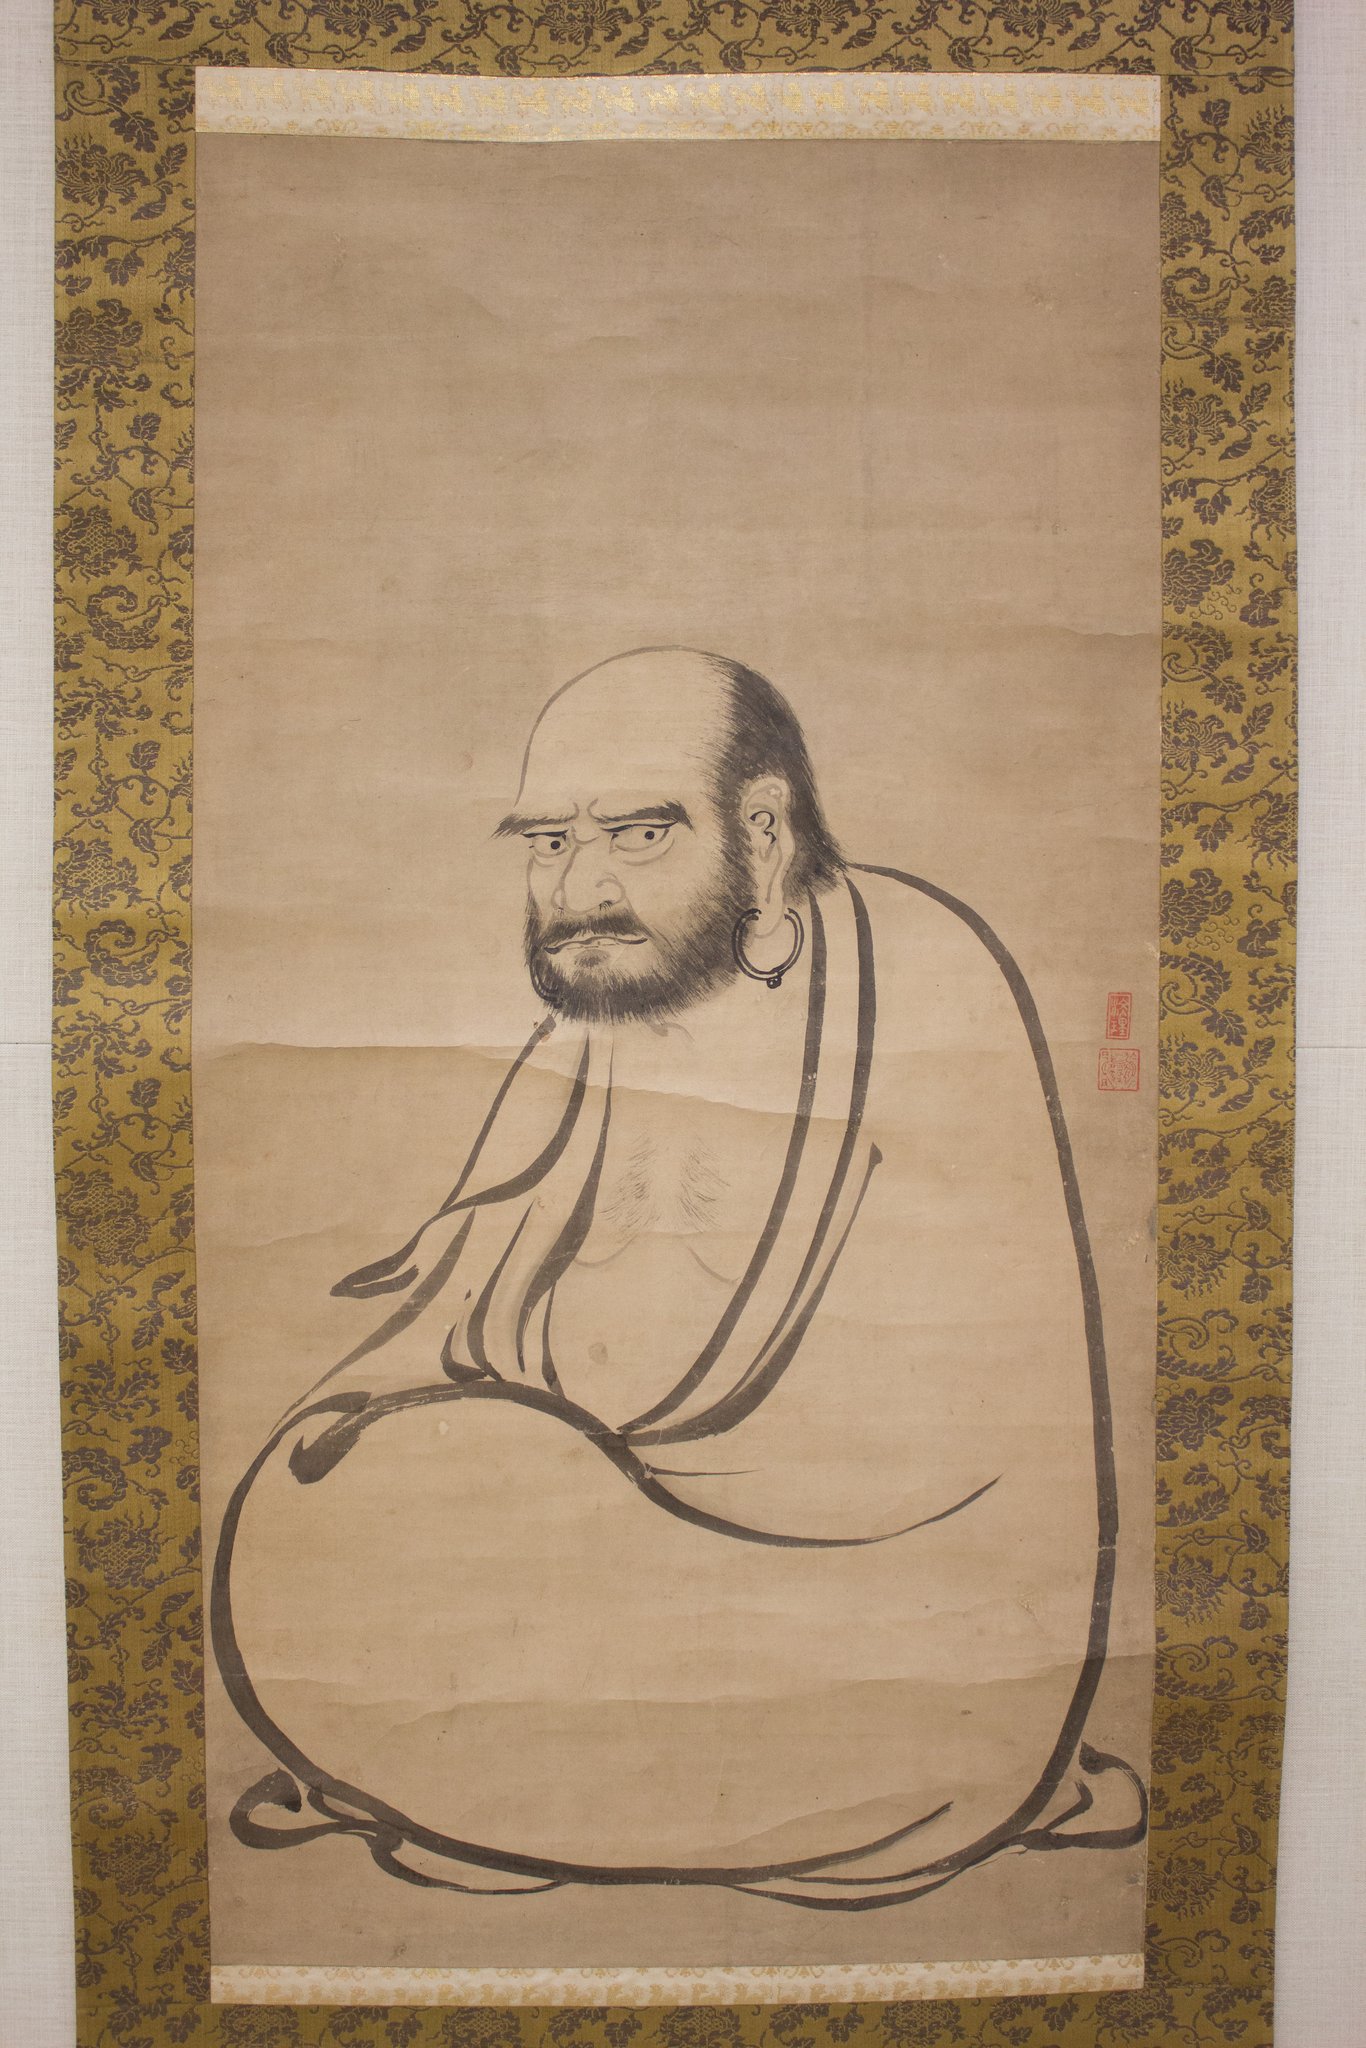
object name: hanging scroll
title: Bodhidharma (Daruma)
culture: japanese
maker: kano sanraku 狩野山楽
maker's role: artist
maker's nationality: japanese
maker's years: 1559-1635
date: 1601-1700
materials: ink, paper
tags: men,buddhism,monks